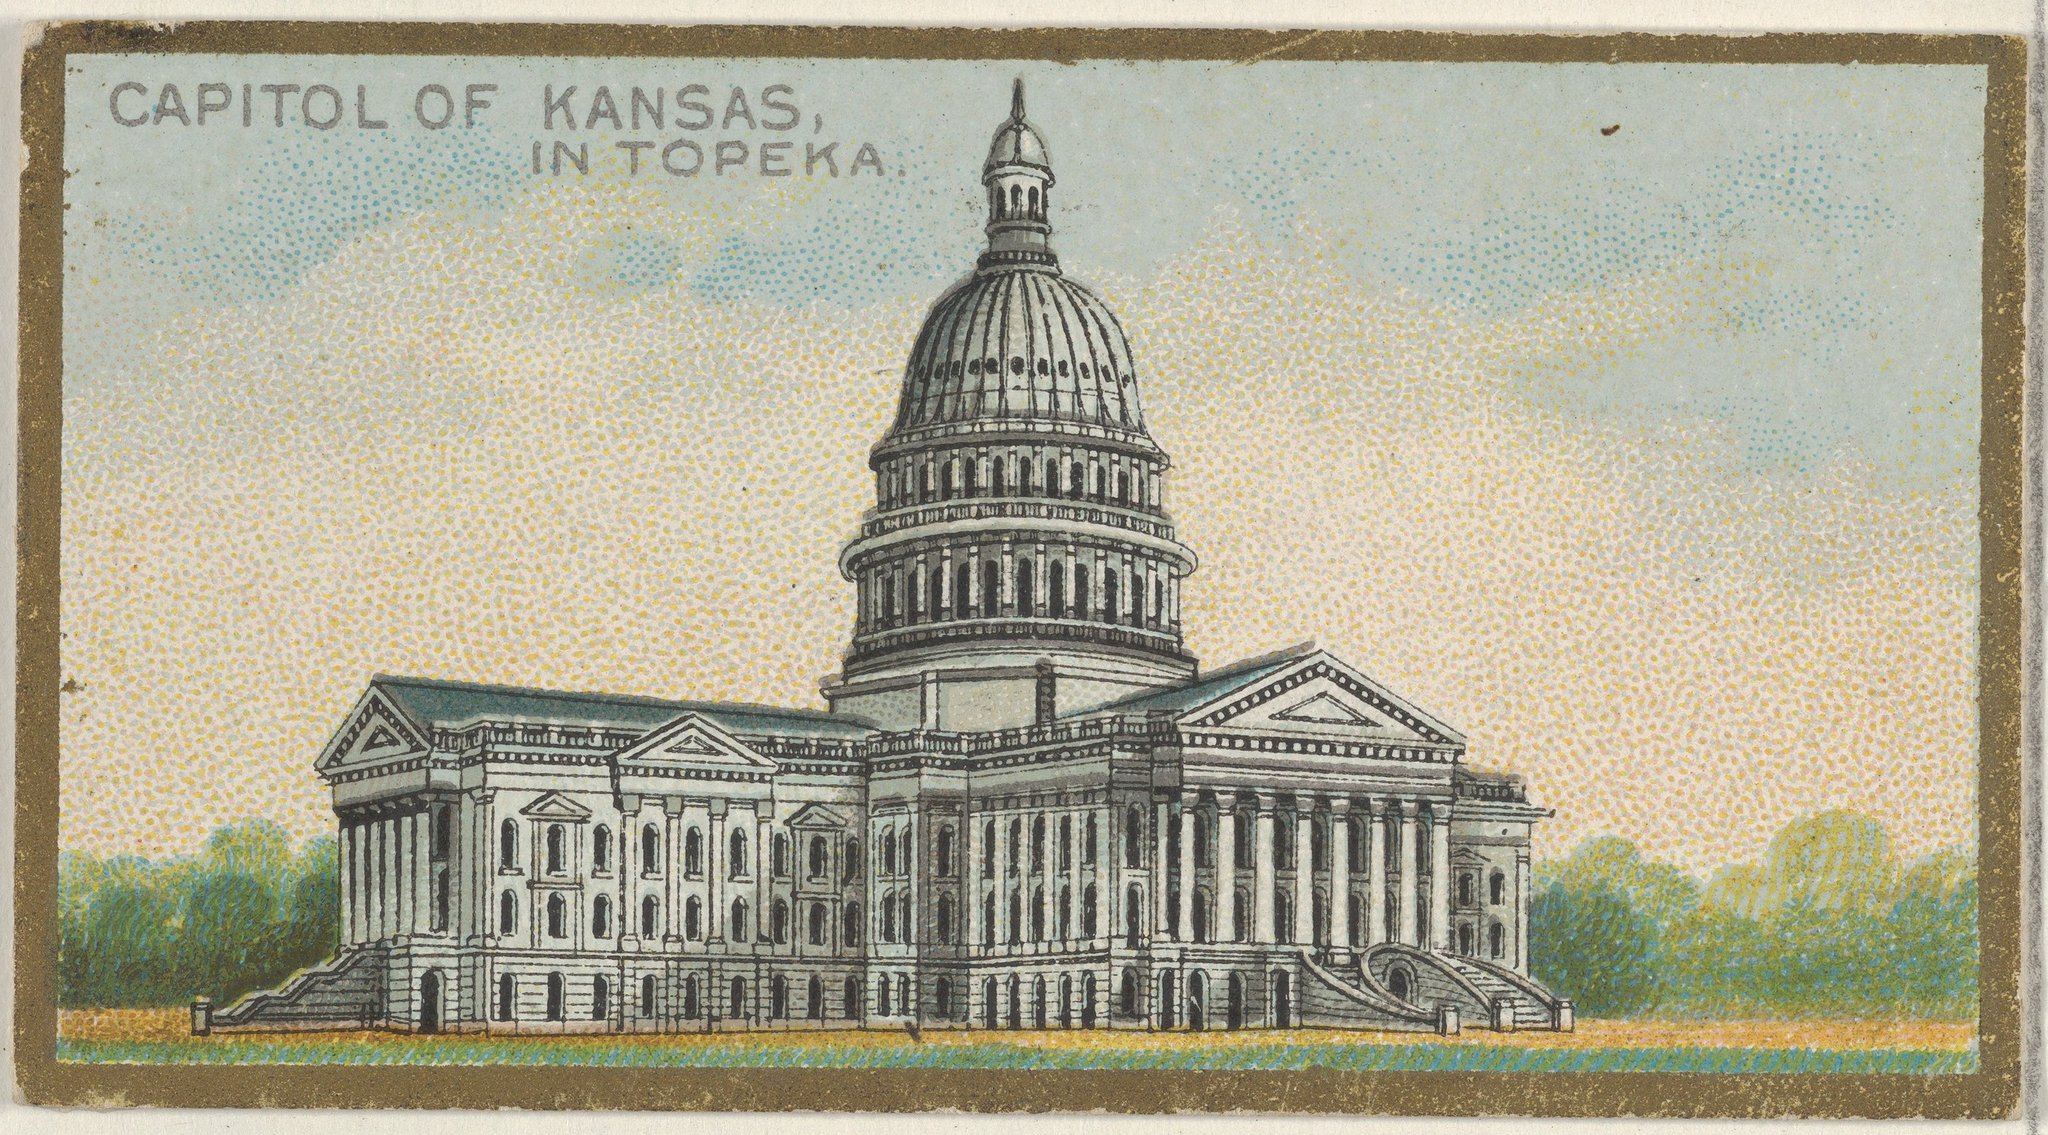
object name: print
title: Capitol of Kansas in Topeka, from the General Government and State Capitol Buildings series (N14) for Allen & Ginter Cigarettes Brands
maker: allen & ginter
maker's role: publisher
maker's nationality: american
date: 1889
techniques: color lithograph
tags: buildings